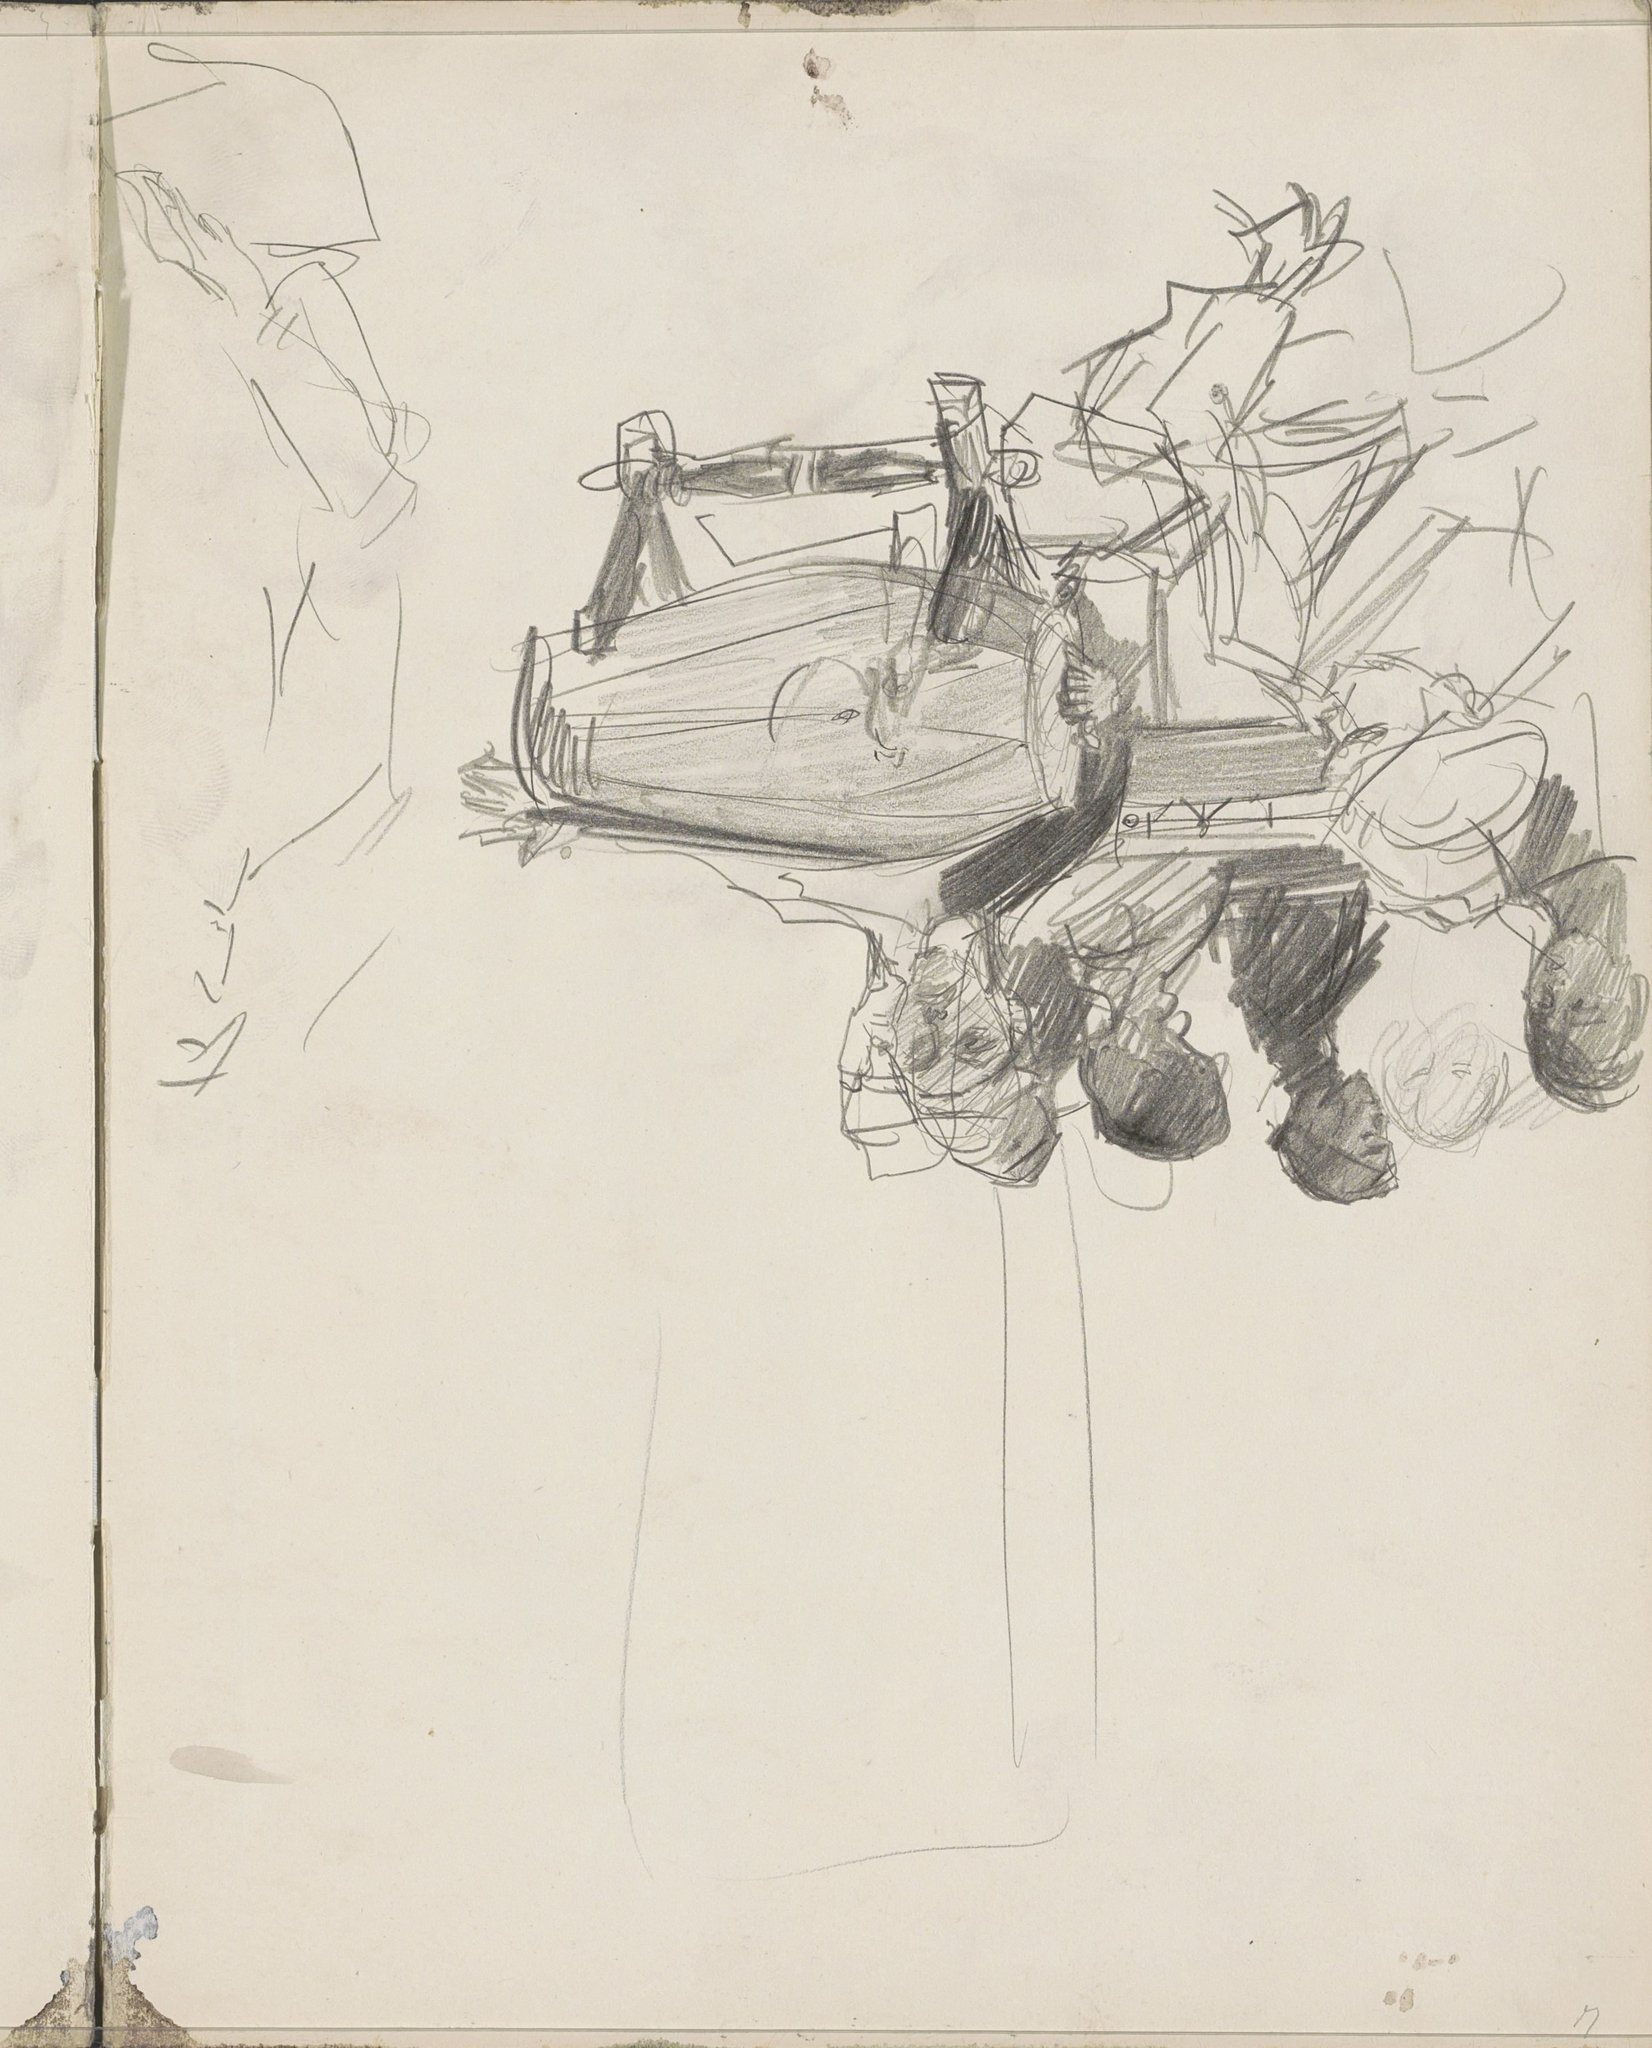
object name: sketchbook leaf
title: Zittende figuren, onder wie een trommelaar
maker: isaac israels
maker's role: draughtsman, painter, print maker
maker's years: 1865-1934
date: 1921-1922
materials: paper, pencil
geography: dutch east indies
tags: asiatic races and peoples, sitting figure, drum (musical instrument), dutch east indies, the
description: Blad 7 recto uit schetsboek XIX met 22 bladen.